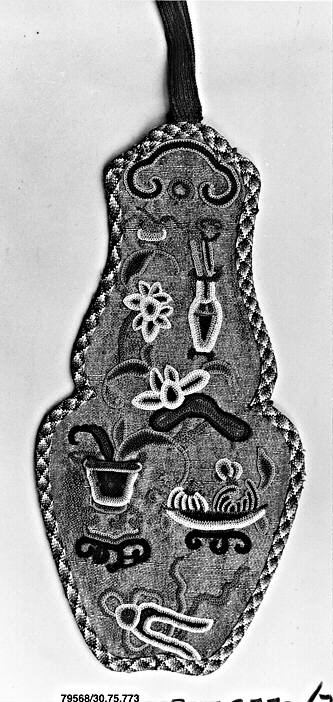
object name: bag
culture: chinese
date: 1701-1900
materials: metal, silk